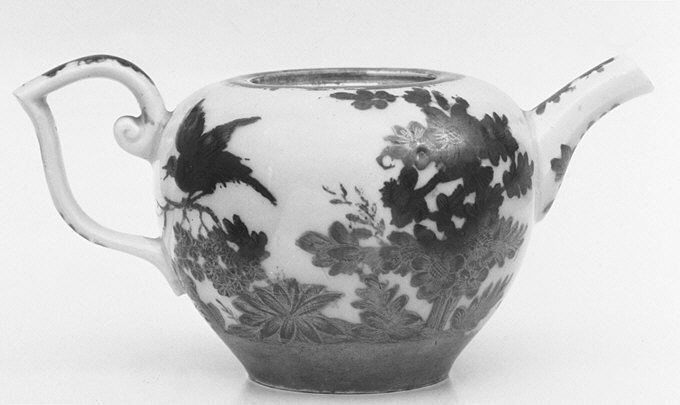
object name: teapot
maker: meissen manufactory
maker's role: manufactory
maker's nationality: german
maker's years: 1710-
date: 1740-1750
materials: hard paste porcelain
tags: birds,flowers